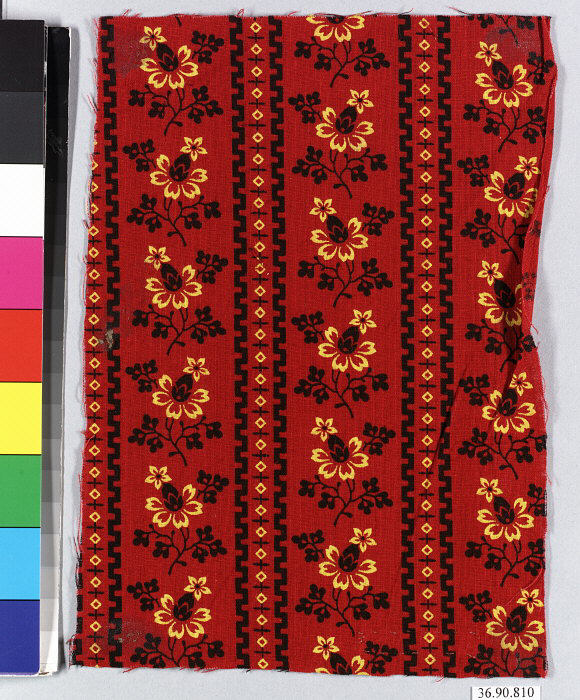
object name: piece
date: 1867-1900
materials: cotton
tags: flowers,leaves